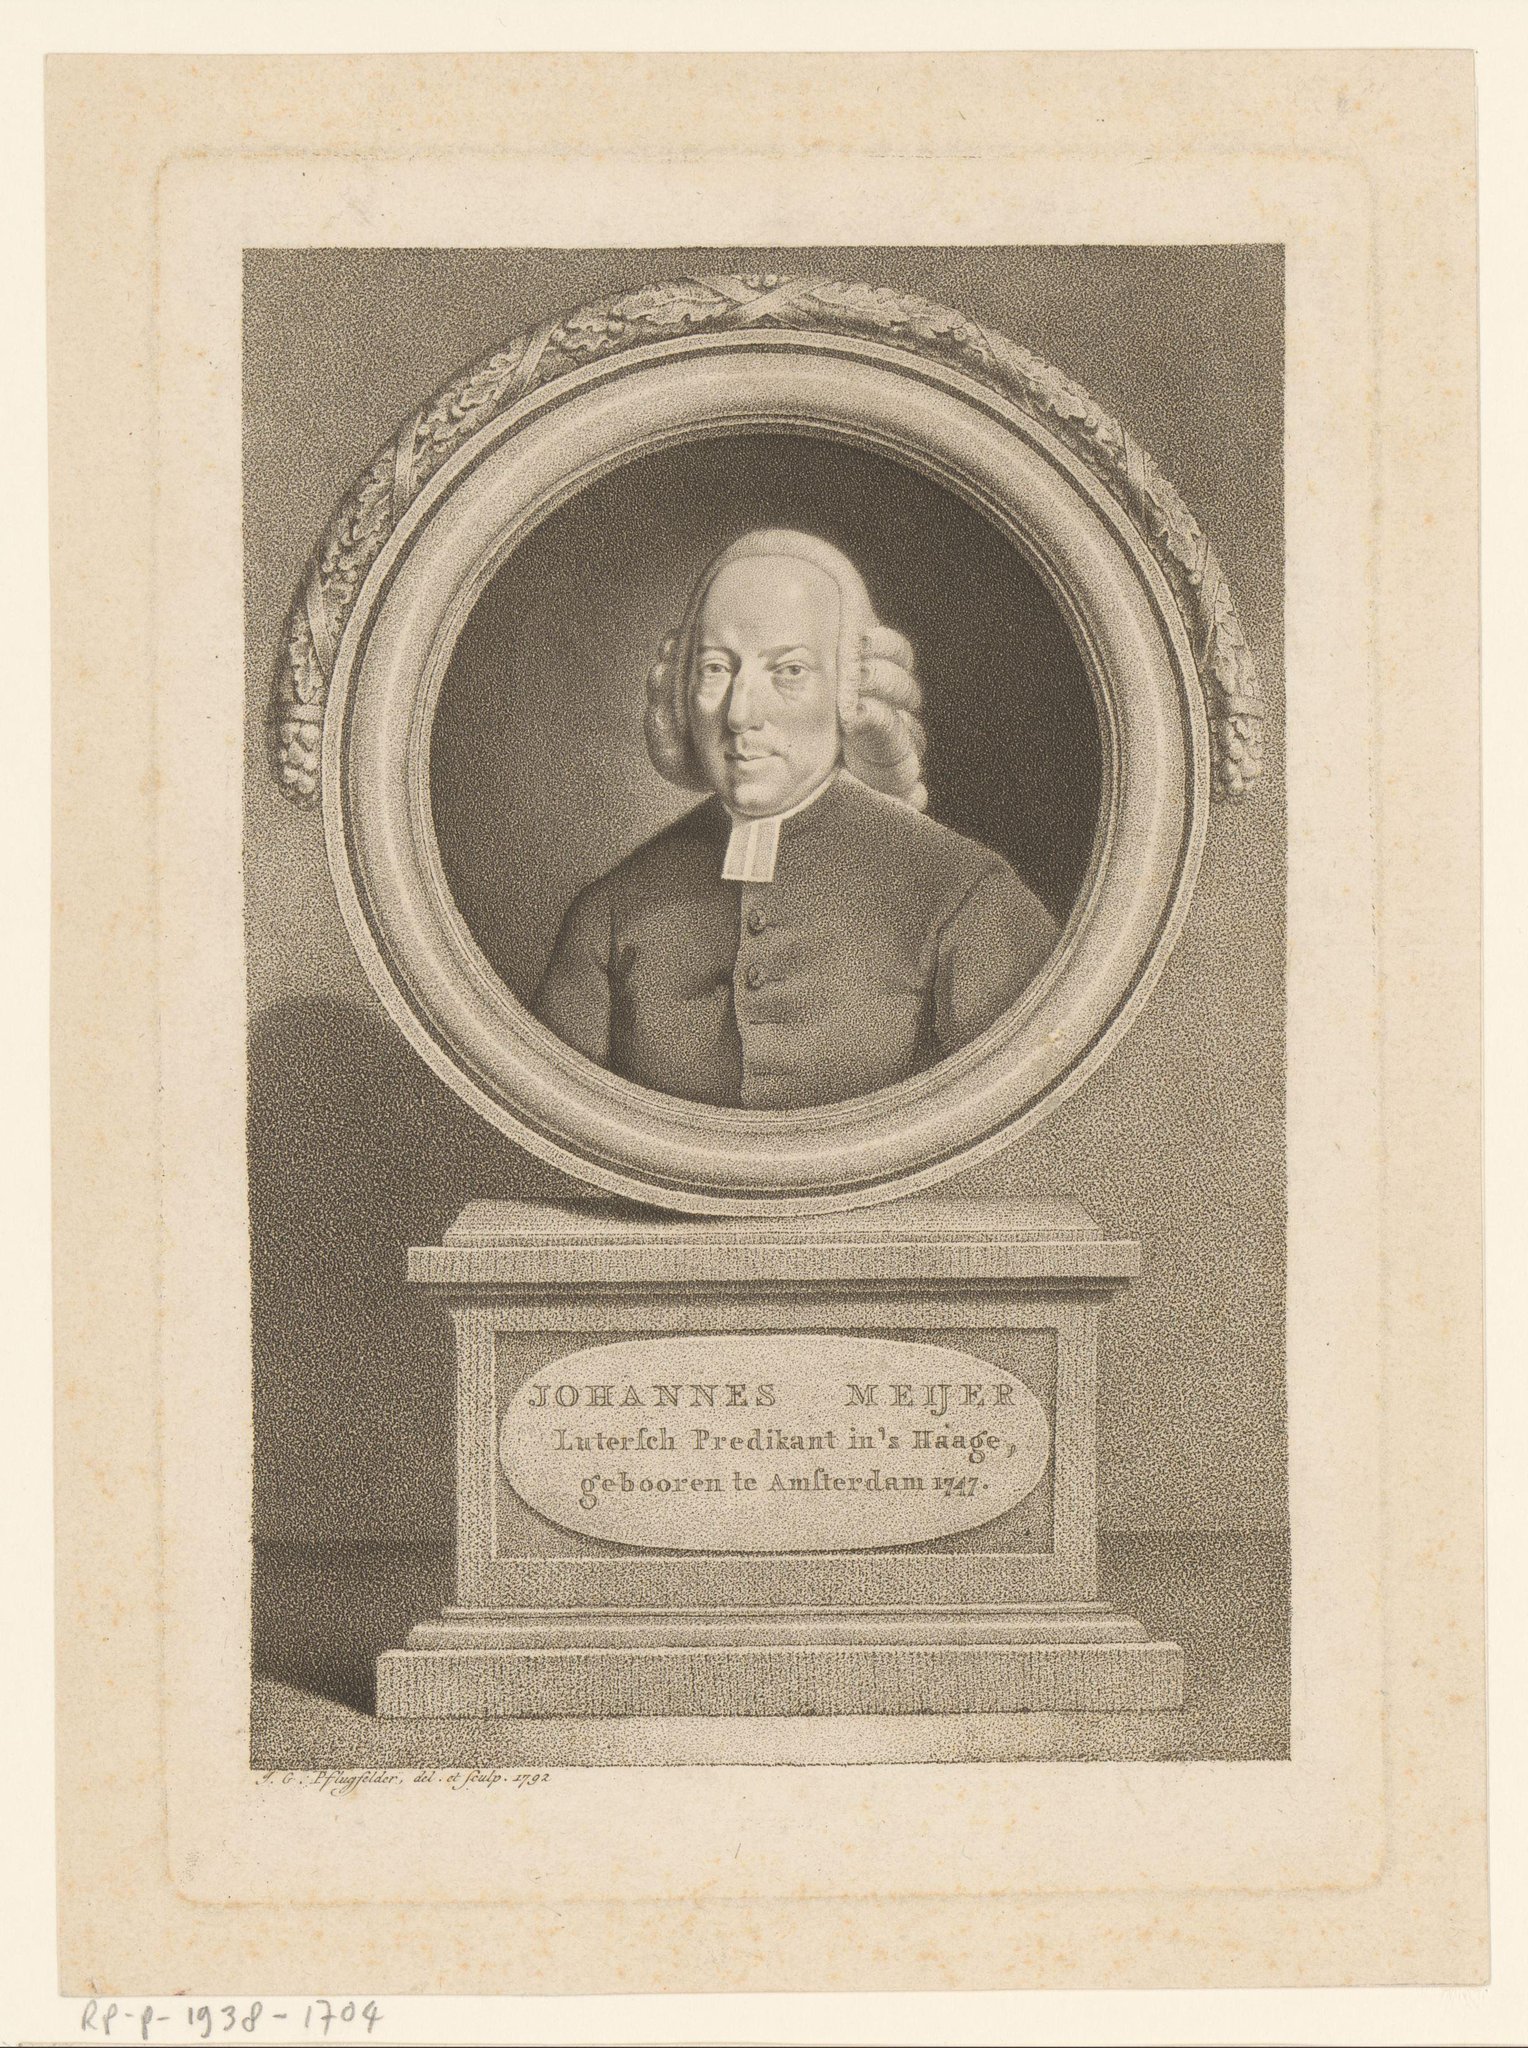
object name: print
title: Portret van Johannes Meijer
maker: johann gottfried pflugfelder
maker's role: print maker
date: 1792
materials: paper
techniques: stippled etching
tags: amsterdam, historical persons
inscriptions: collector's mark: Lugt 2228